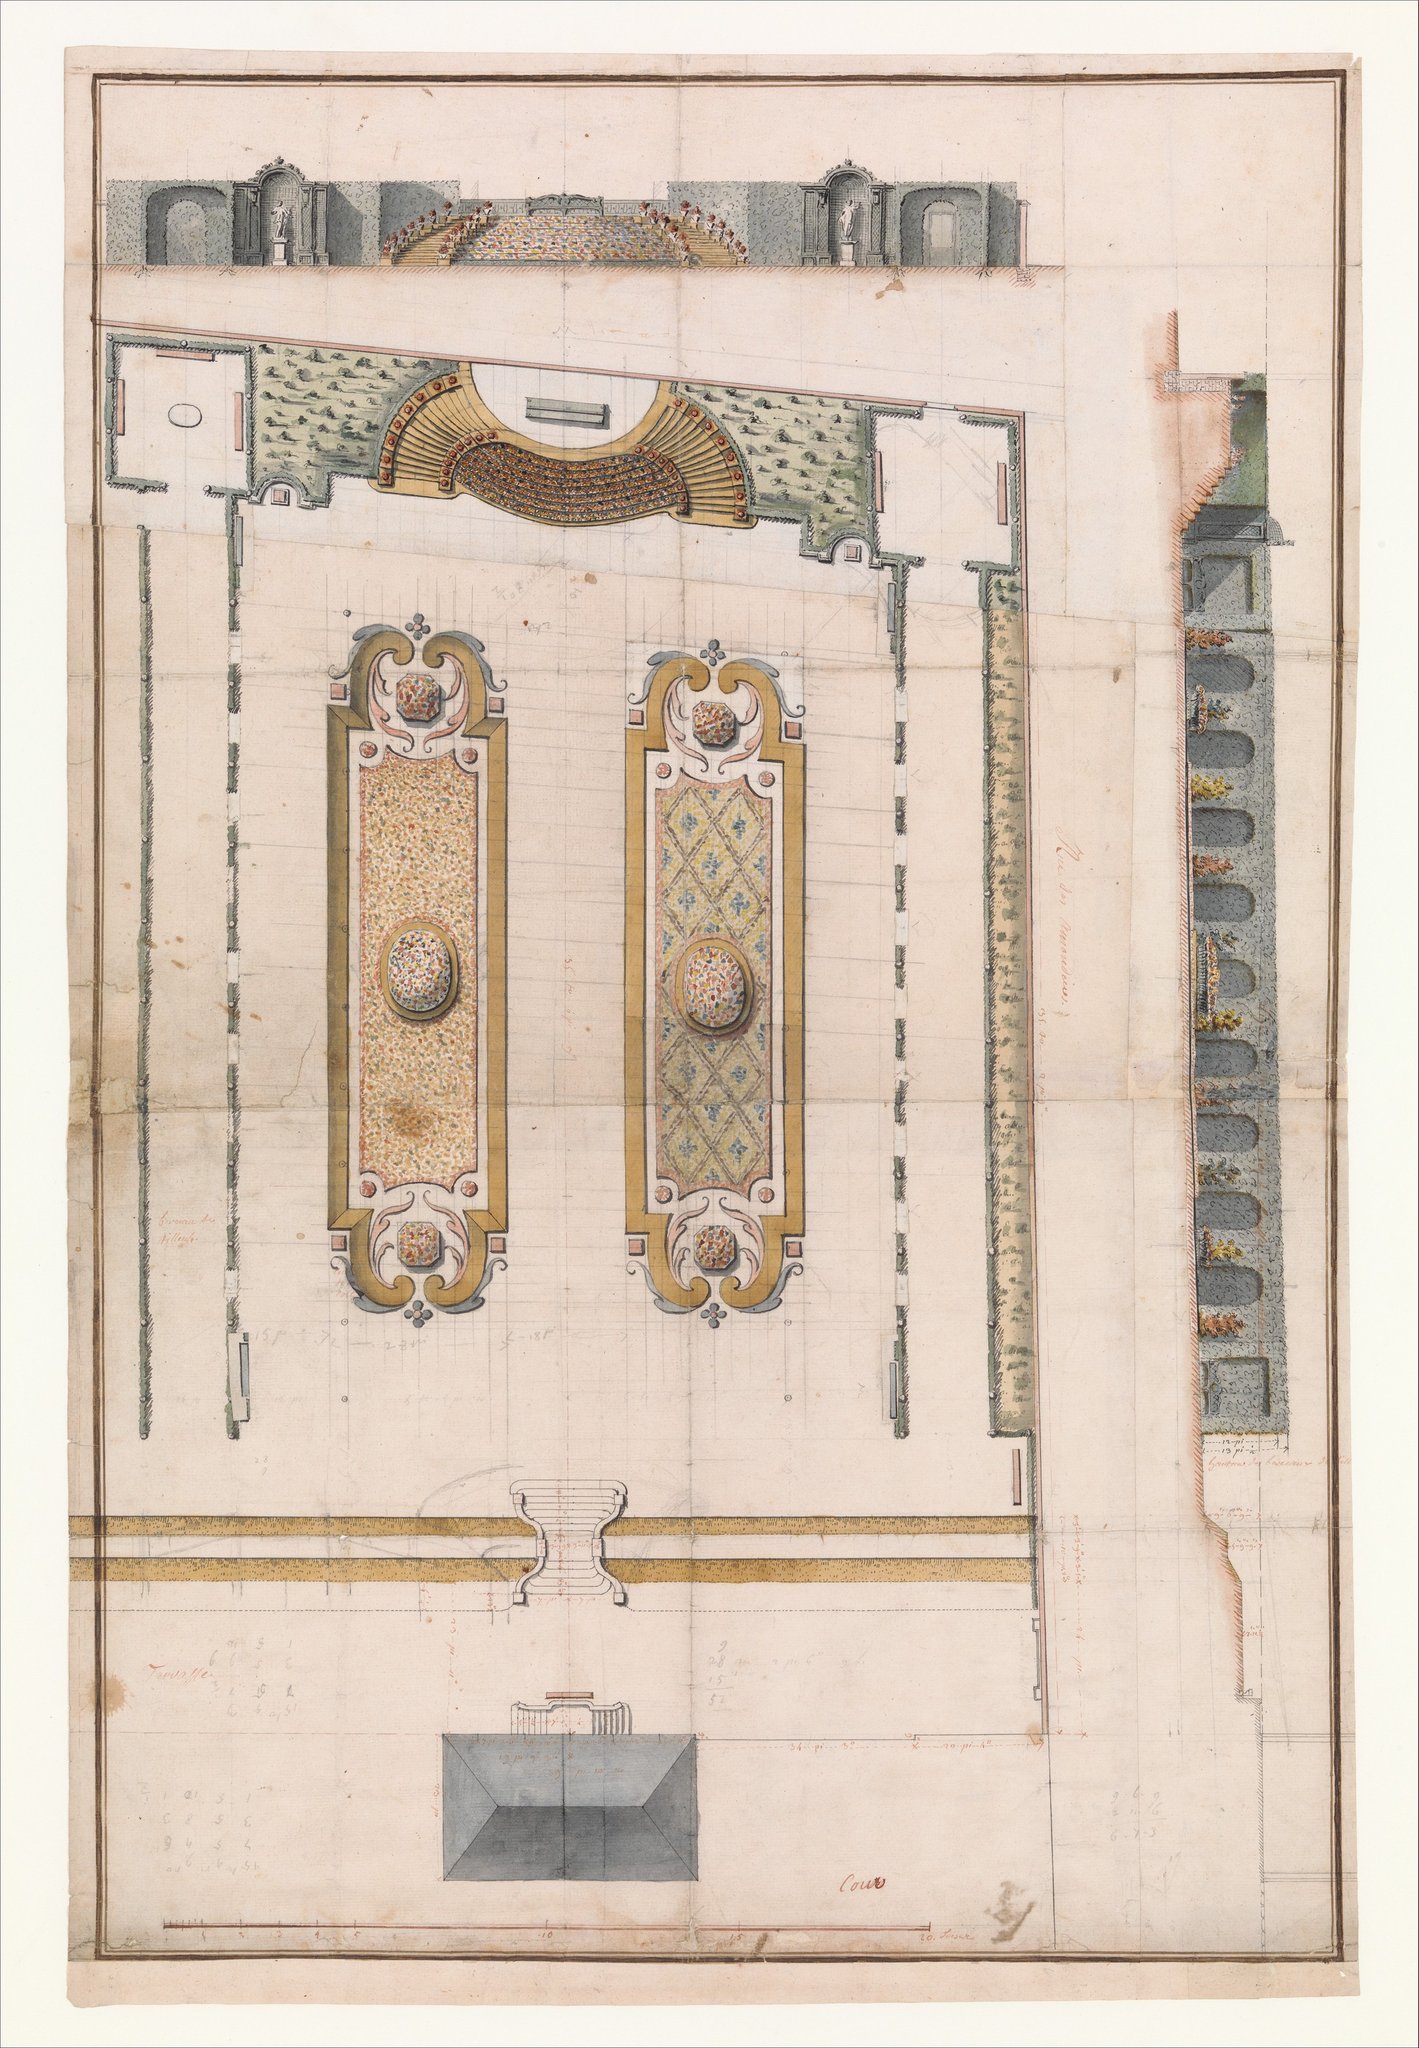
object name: drawing ornament architecture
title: Design for the Garden of a Hotel on Rue des Amandiers, Paris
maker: anonymous, french, 18th century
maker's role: artist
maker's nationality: french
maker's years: 1700-1800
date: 1767-1800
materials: graphite, ink, watercolor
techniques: pen